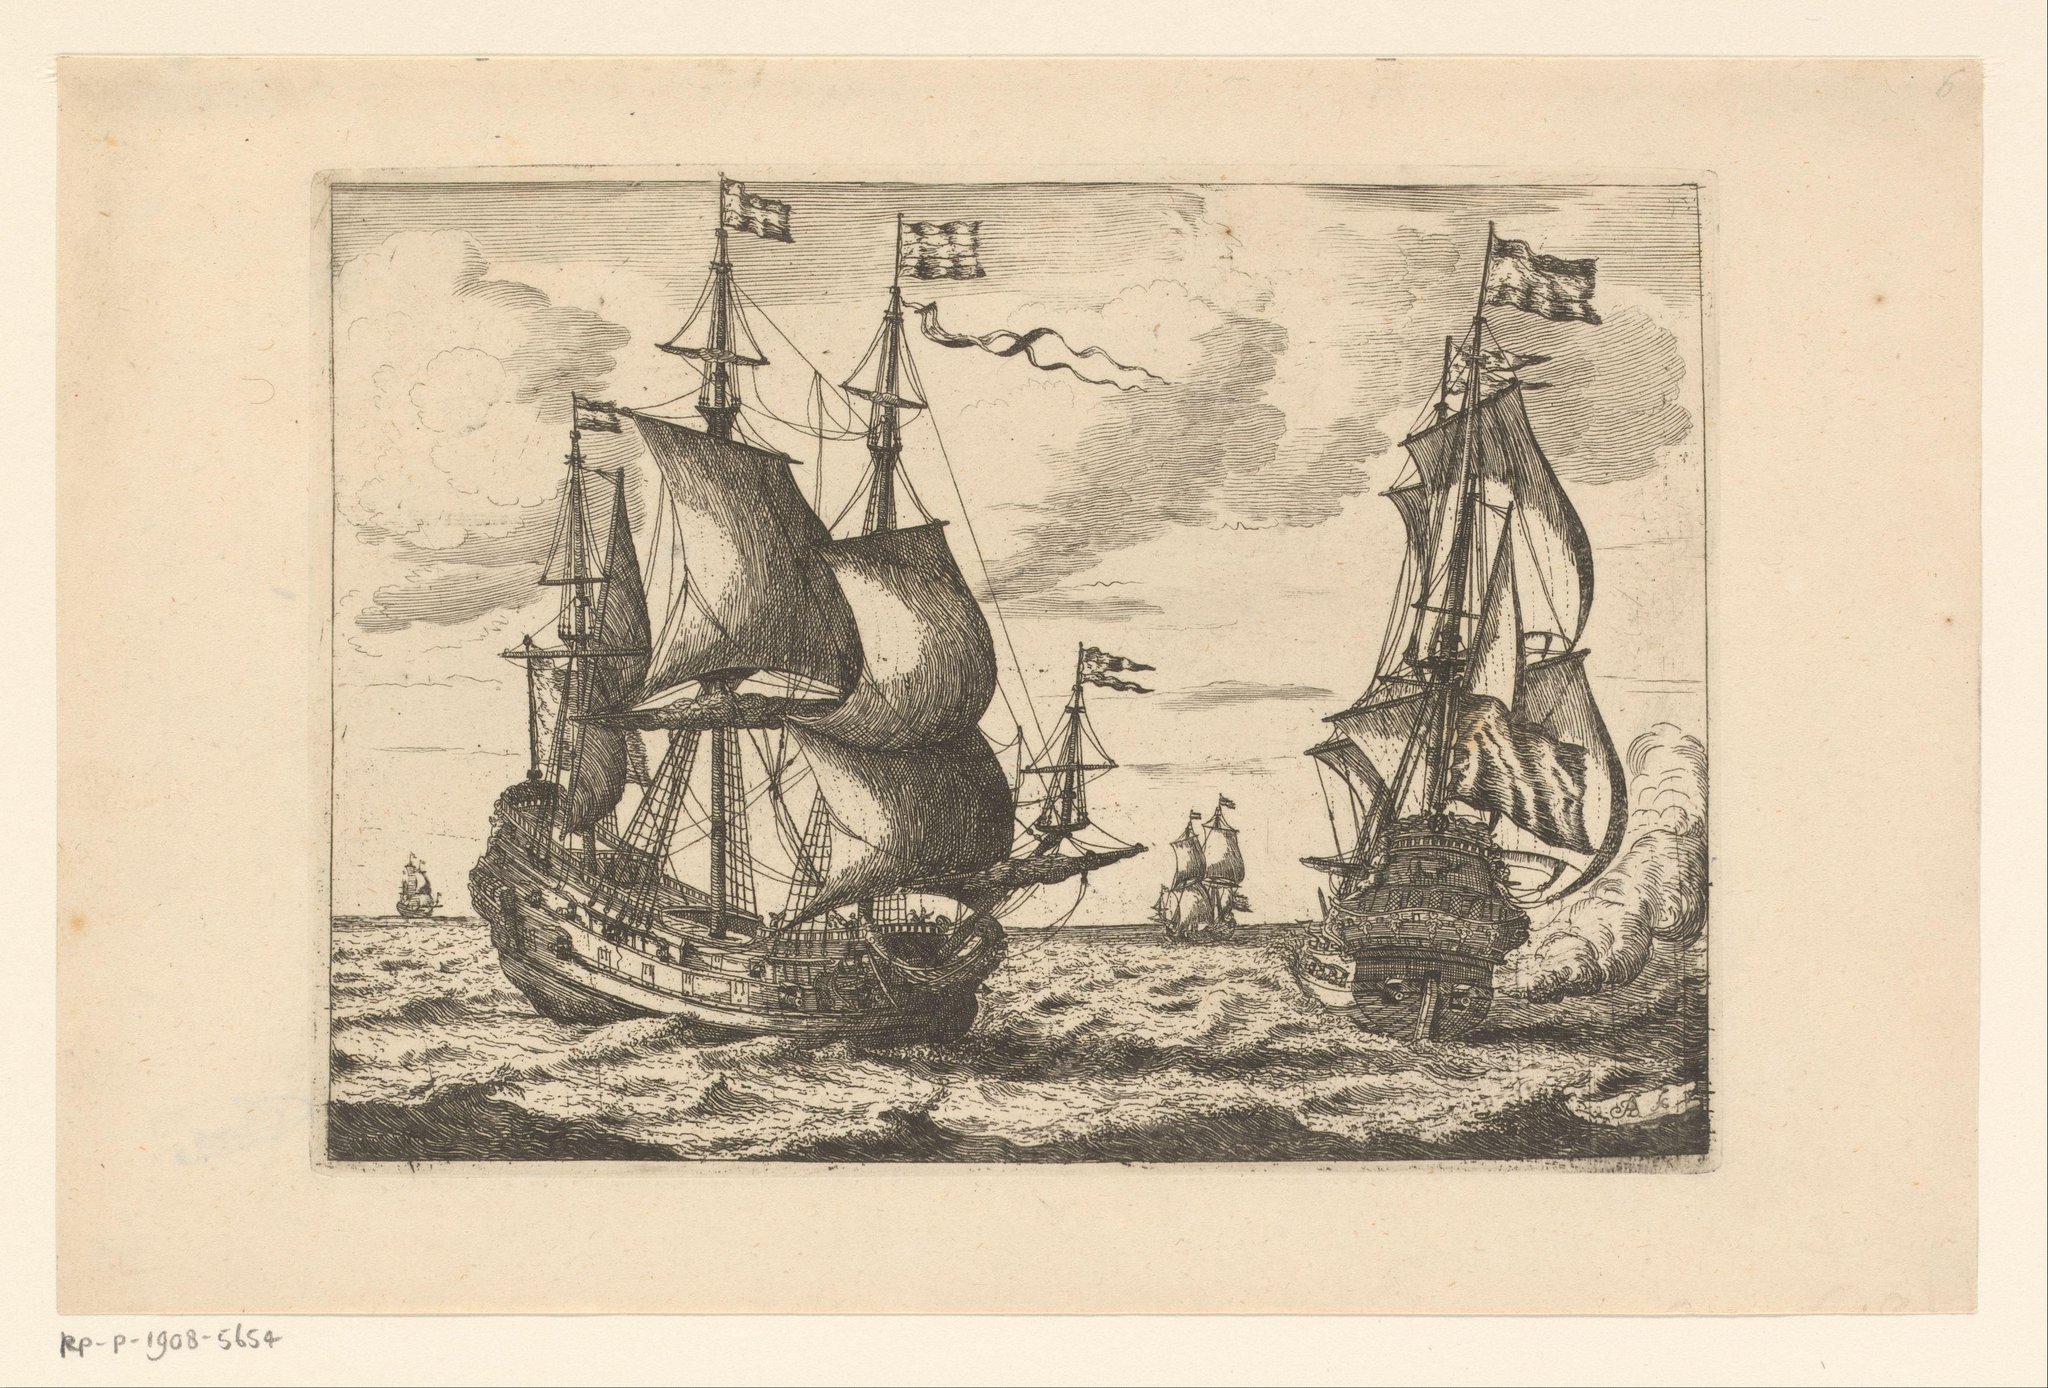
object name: print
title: Oorlogsschepen op zee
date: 1673-1709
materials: paper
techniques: etching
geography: northern netherlands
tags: sailing-ship, sailing-boat, sea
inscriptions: collector's mark: Lugt 2228, collector's mark: Lugt 2162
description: Vier zeilschepen op zee. Het rechter schip vuurt een kanon af.